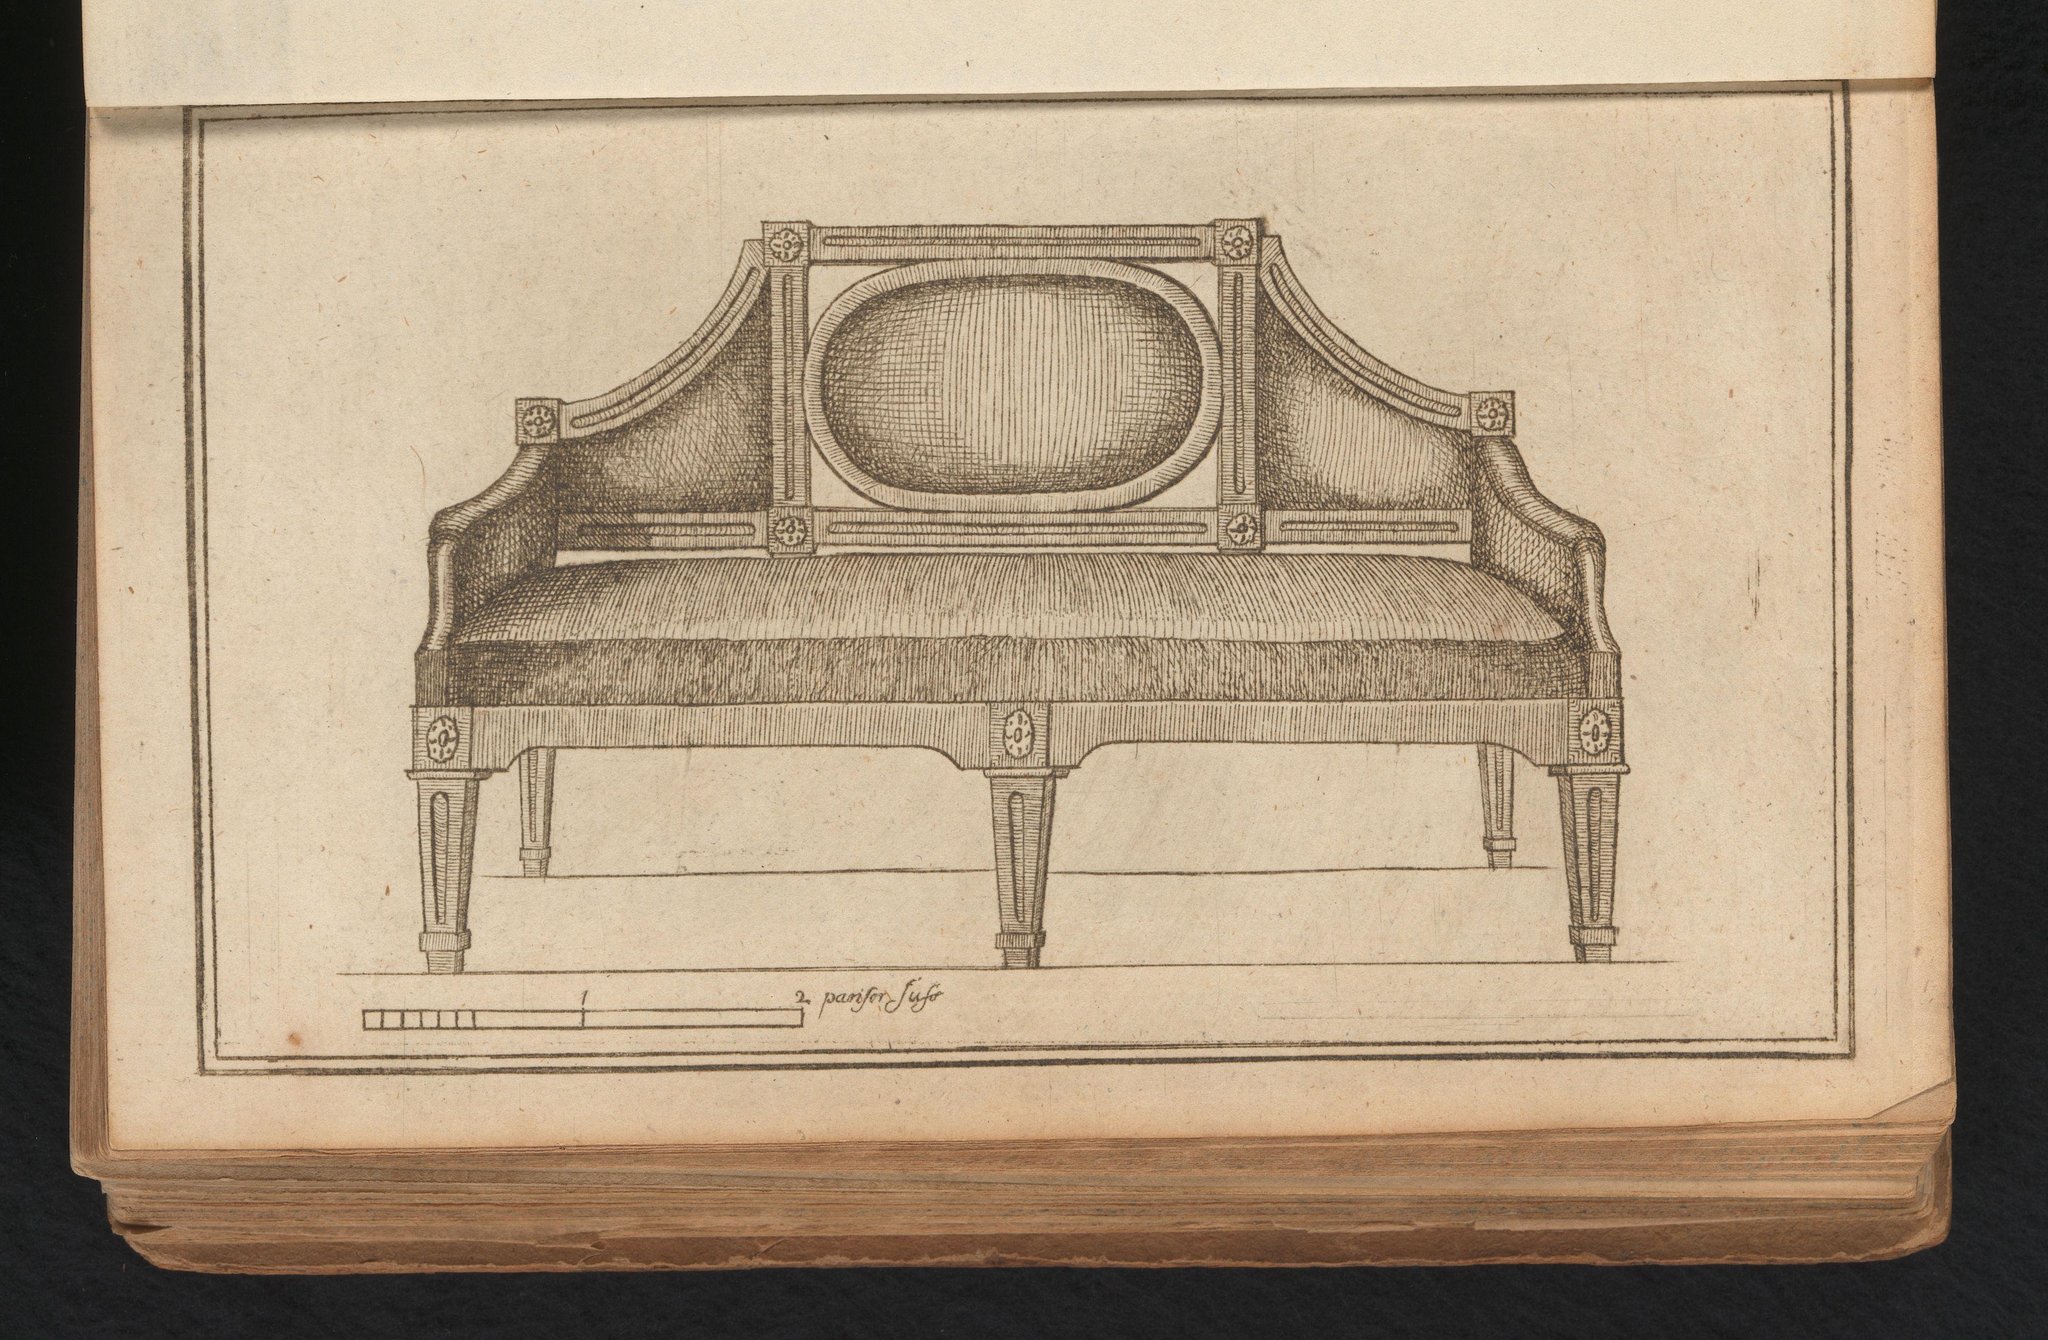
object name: magazine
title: Journal der Moden 1786. T. VII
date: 1786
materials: paper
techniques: etching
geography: gotha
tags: fashion plates